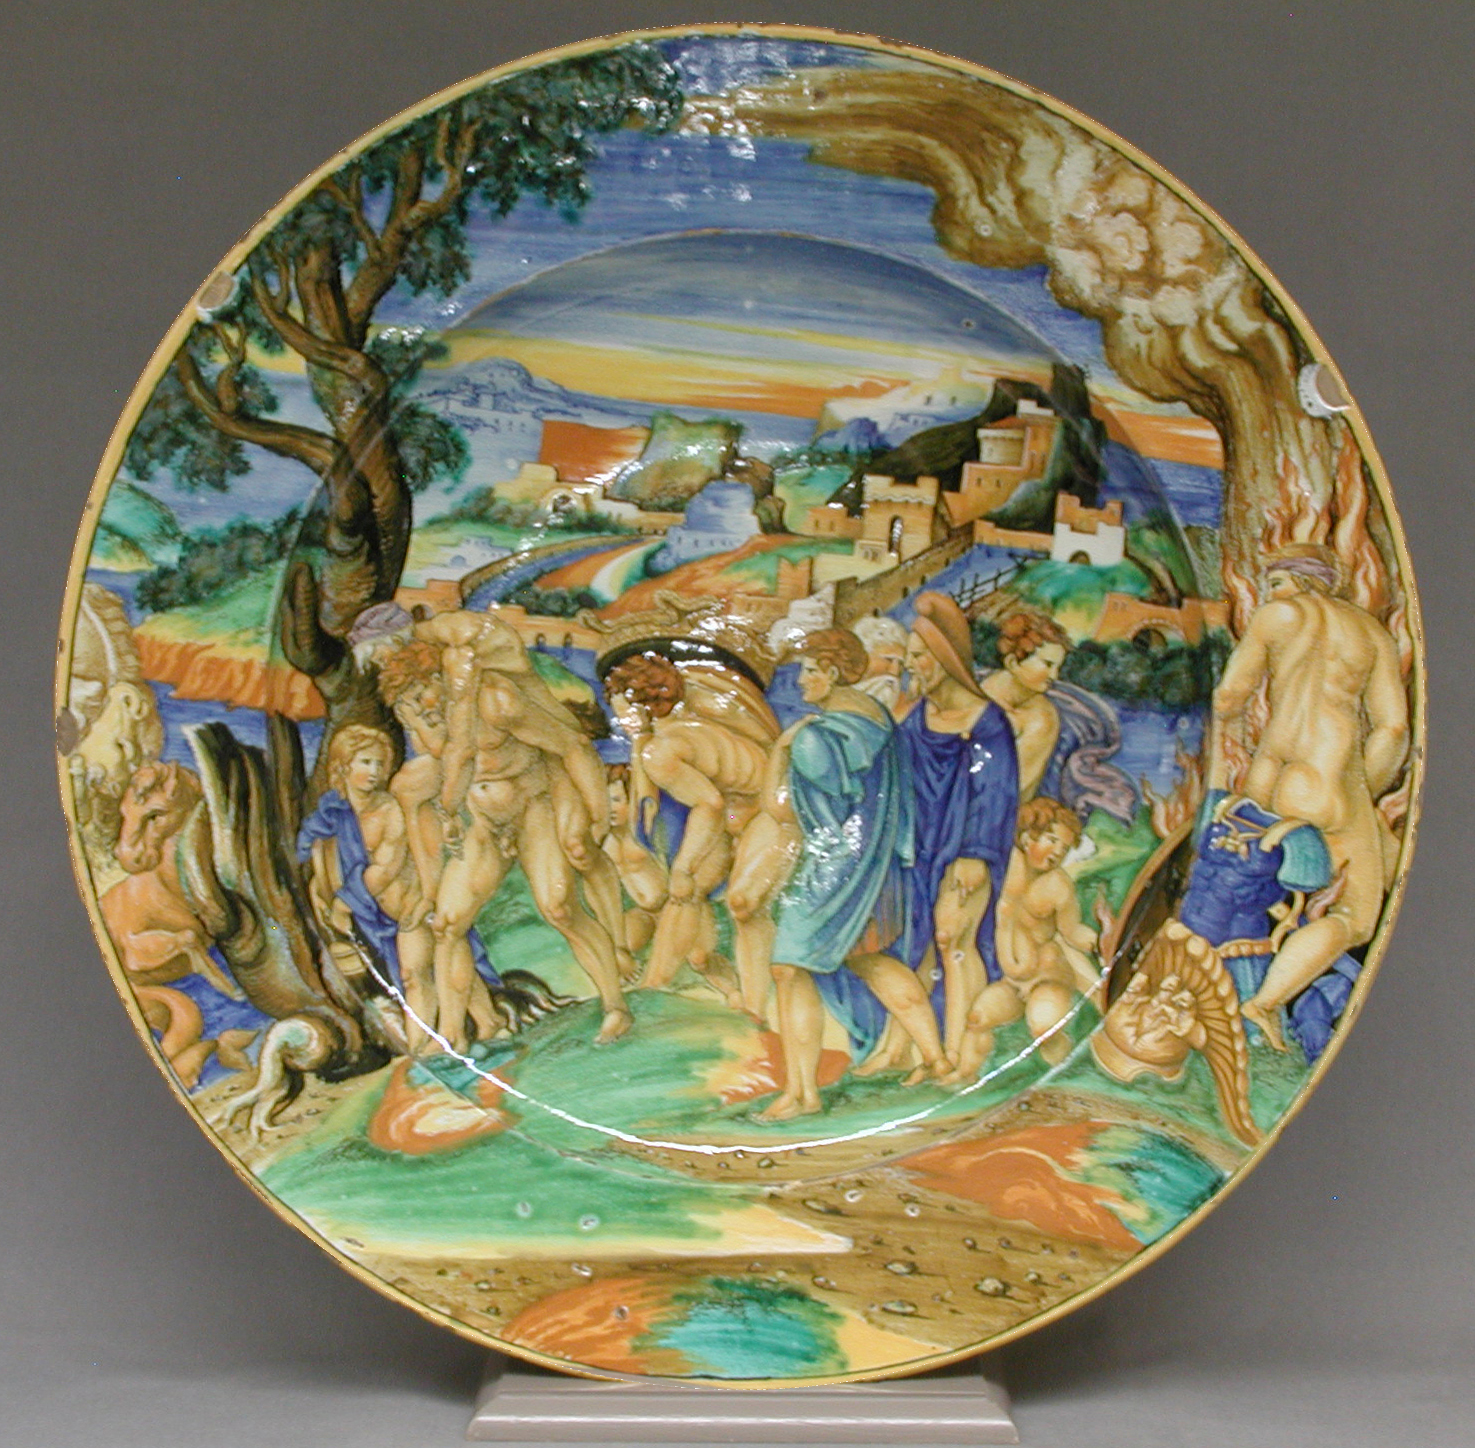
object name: dish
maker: fra xanto avelli da rovigo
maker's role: artist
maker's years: 1486-1582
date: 1530-1545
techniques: maiolica, glazing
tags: children,male nudes,horses